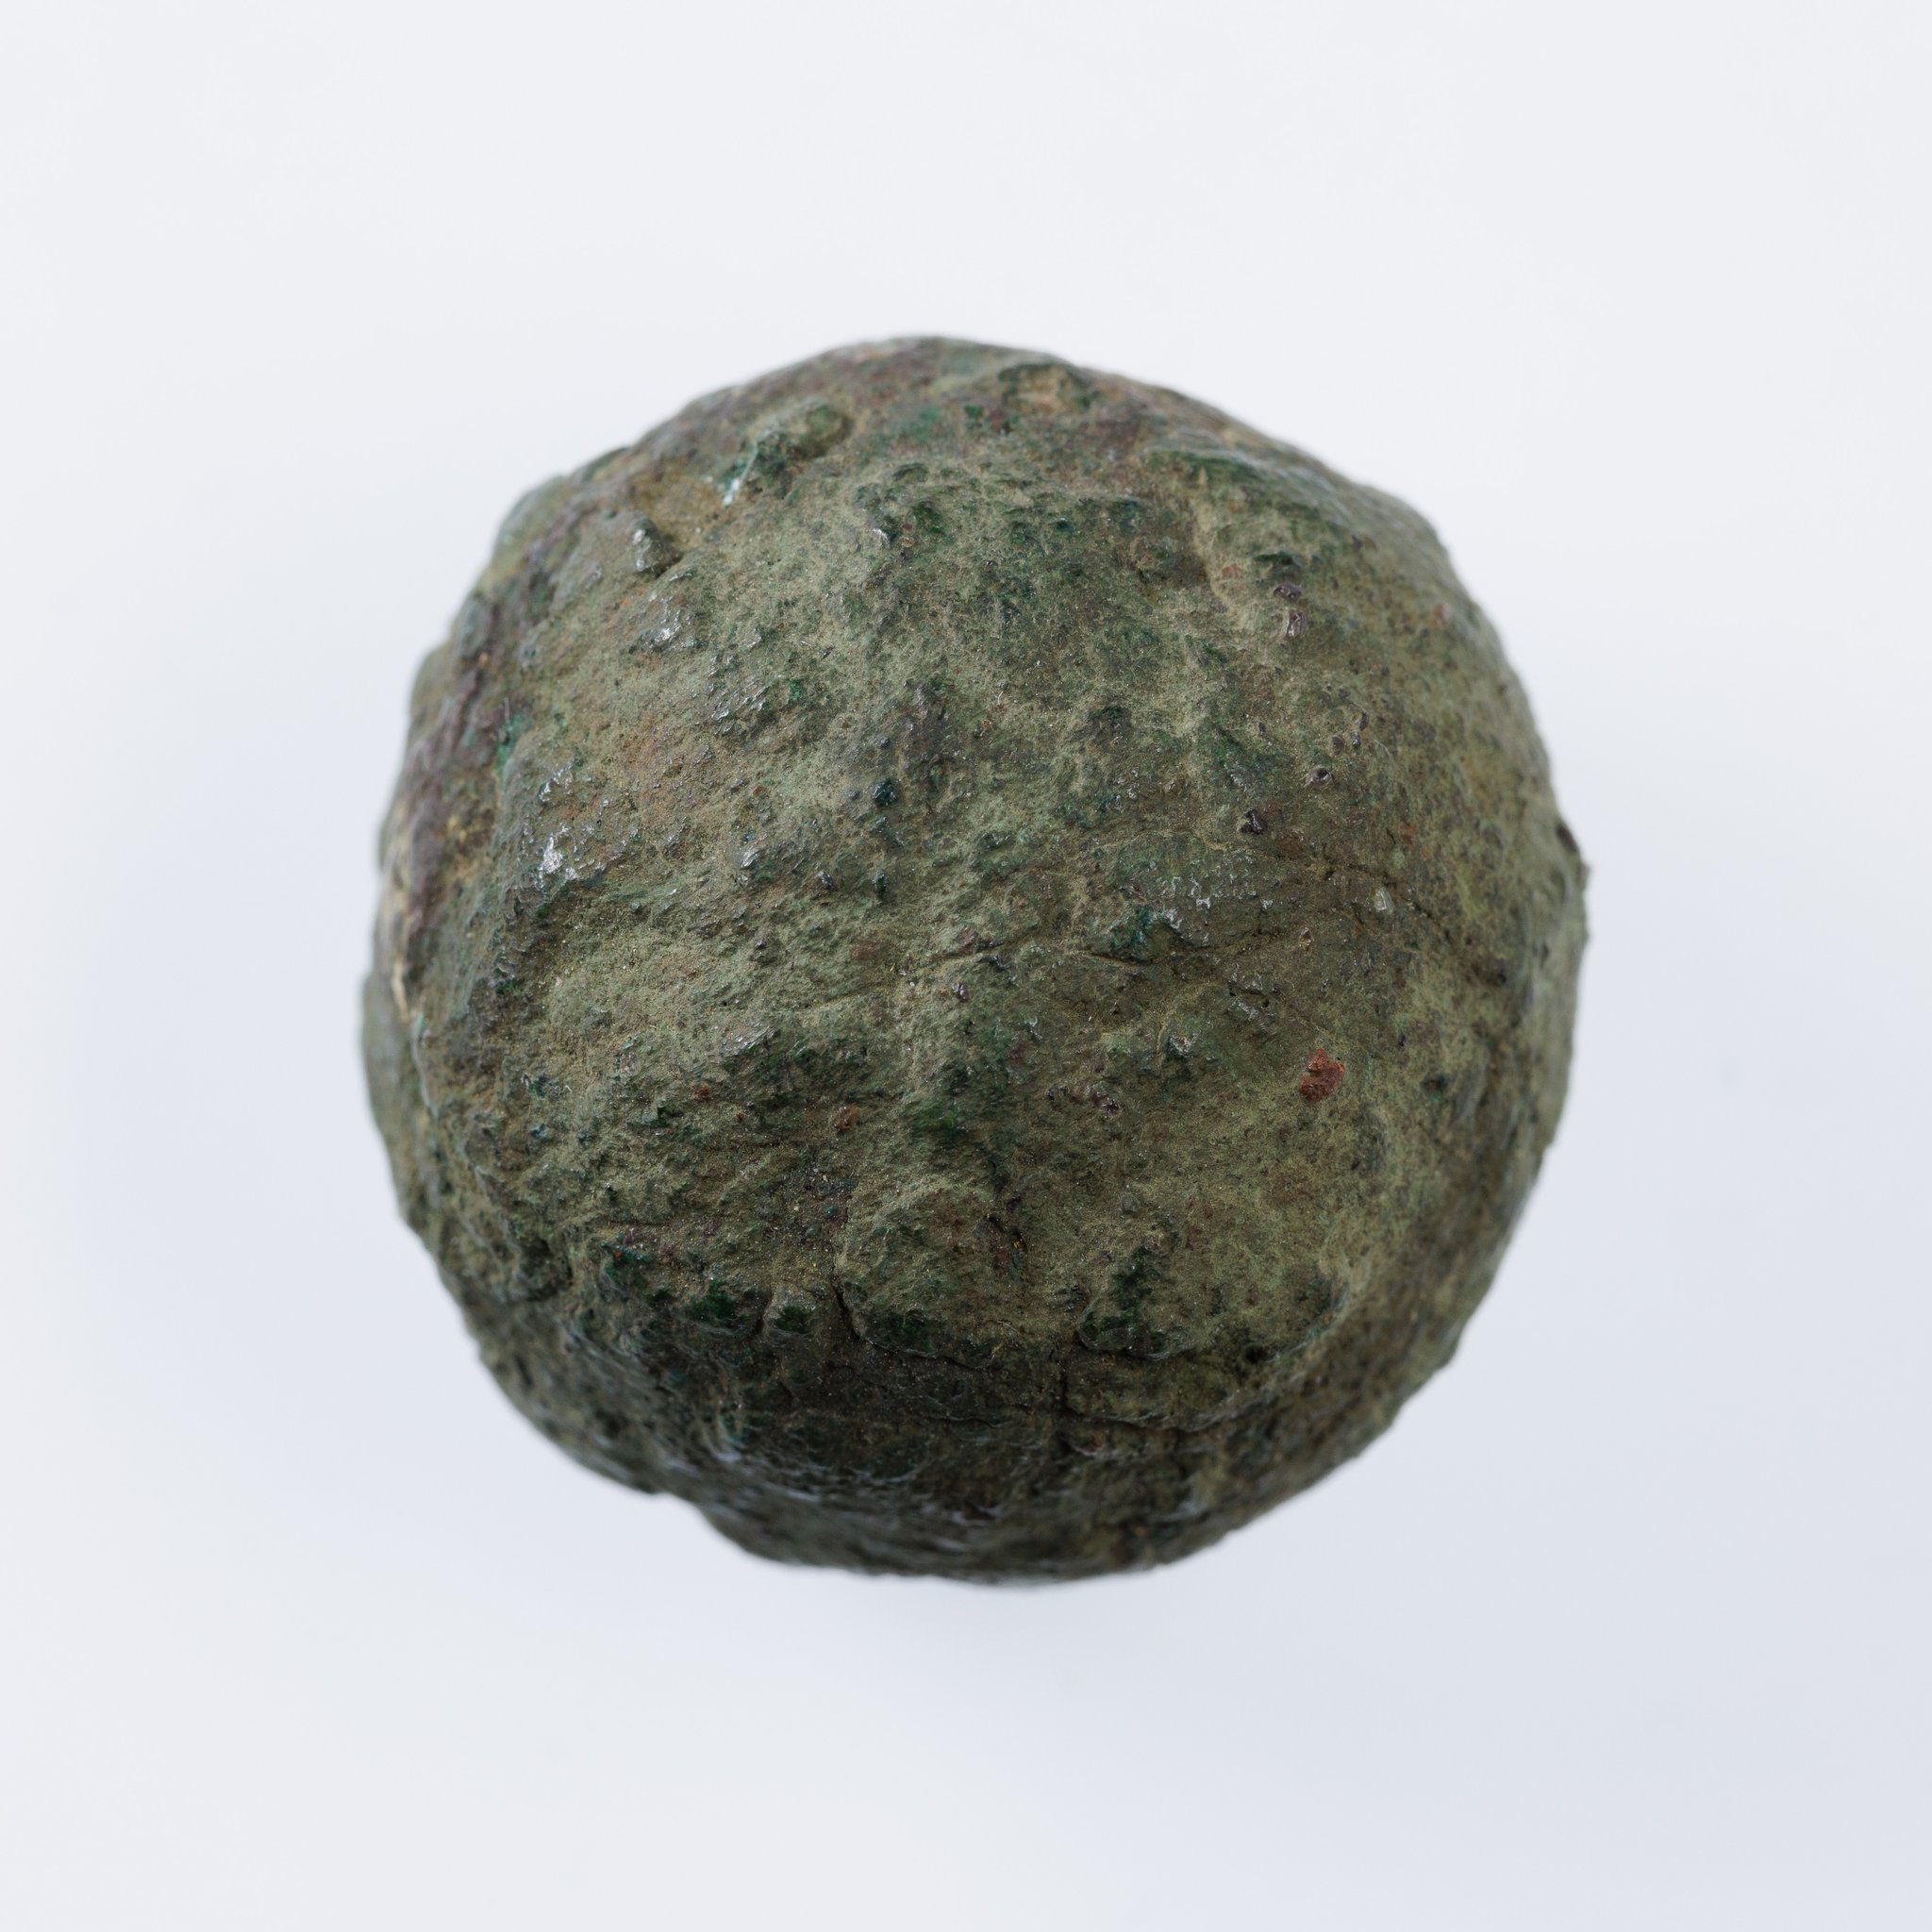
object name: weight, 1 4 kedet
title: Weight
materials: copper alloy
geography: egypt